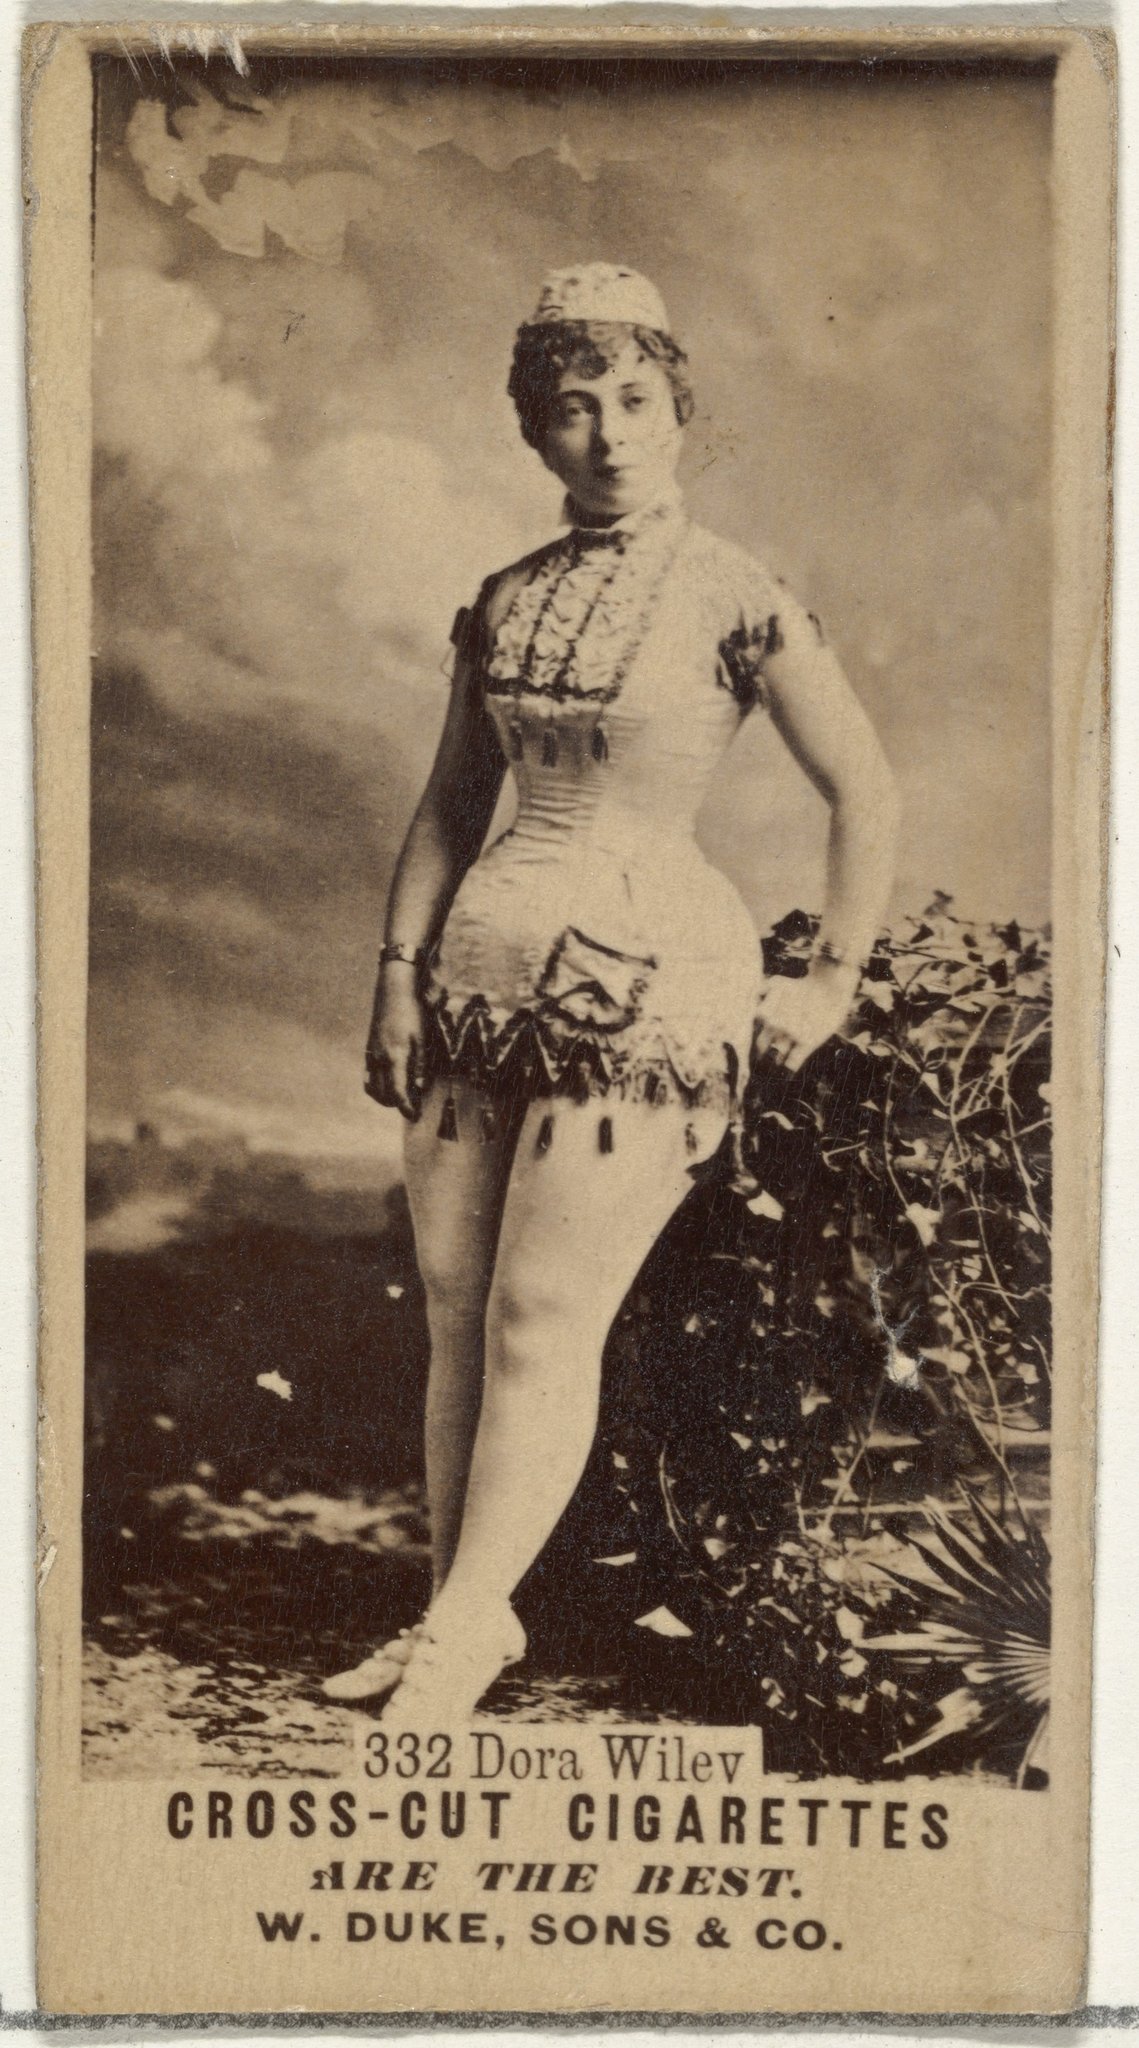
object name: photograph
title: Card Number 332, Dora Wiley, from the Actors and Actresses series (N145-3) issued by Duke Sons & Co. to promote Cross Cut Cigarettes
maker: w. duke, sons & co.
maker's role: publisher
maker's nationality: american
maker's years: 1870-1920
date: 1880-1889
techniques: albumen silver print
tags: portraits,women,actresses